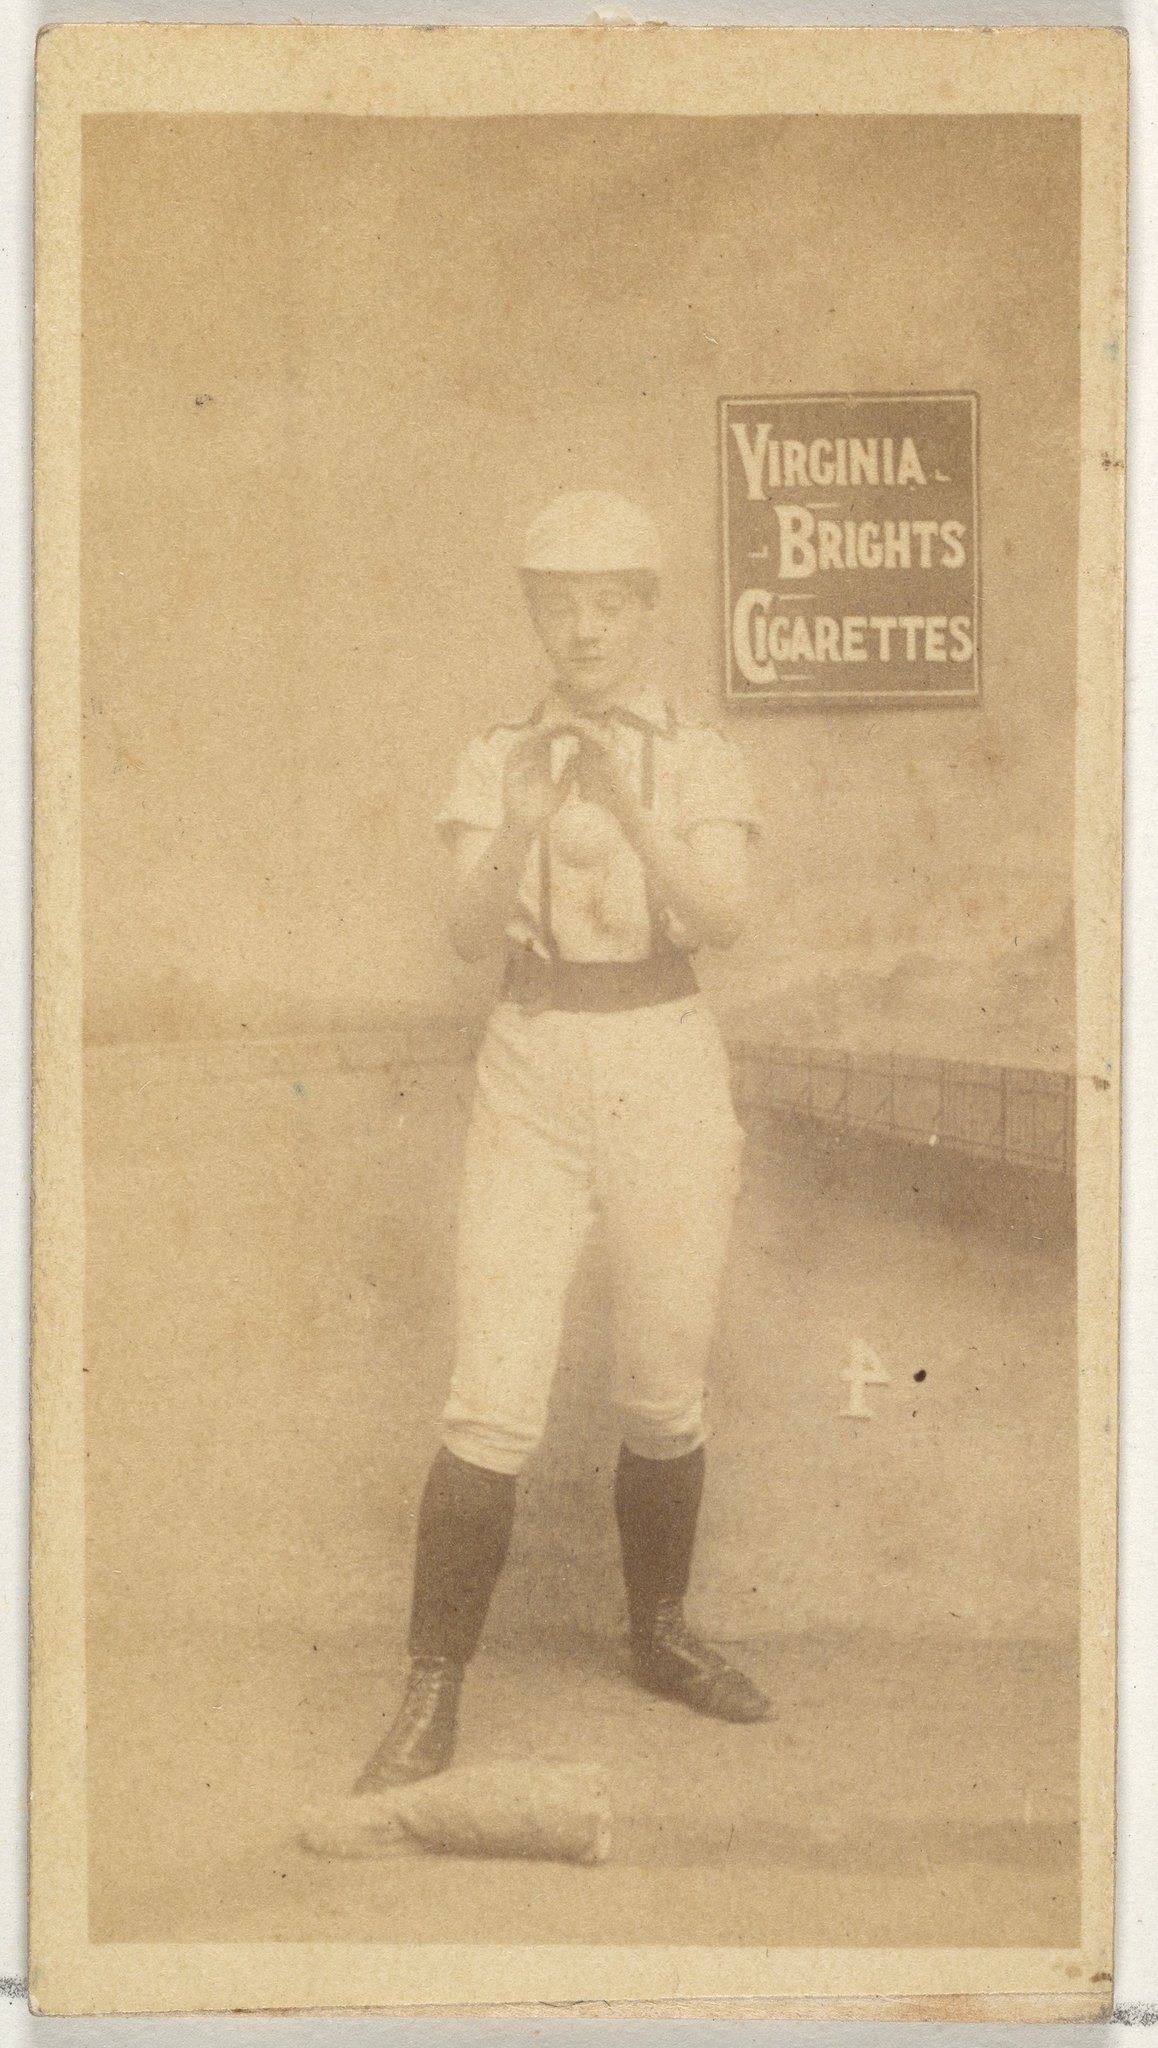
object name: baseball card, photograph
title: Card 4, from the Girl Baseball Players series (N48, Type 2) for Virginia Brights Cigarettes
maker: allen & ginter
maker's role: publisher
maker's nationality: american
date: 1886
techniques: albumen silver print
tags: portraits,women,baseball,athletes